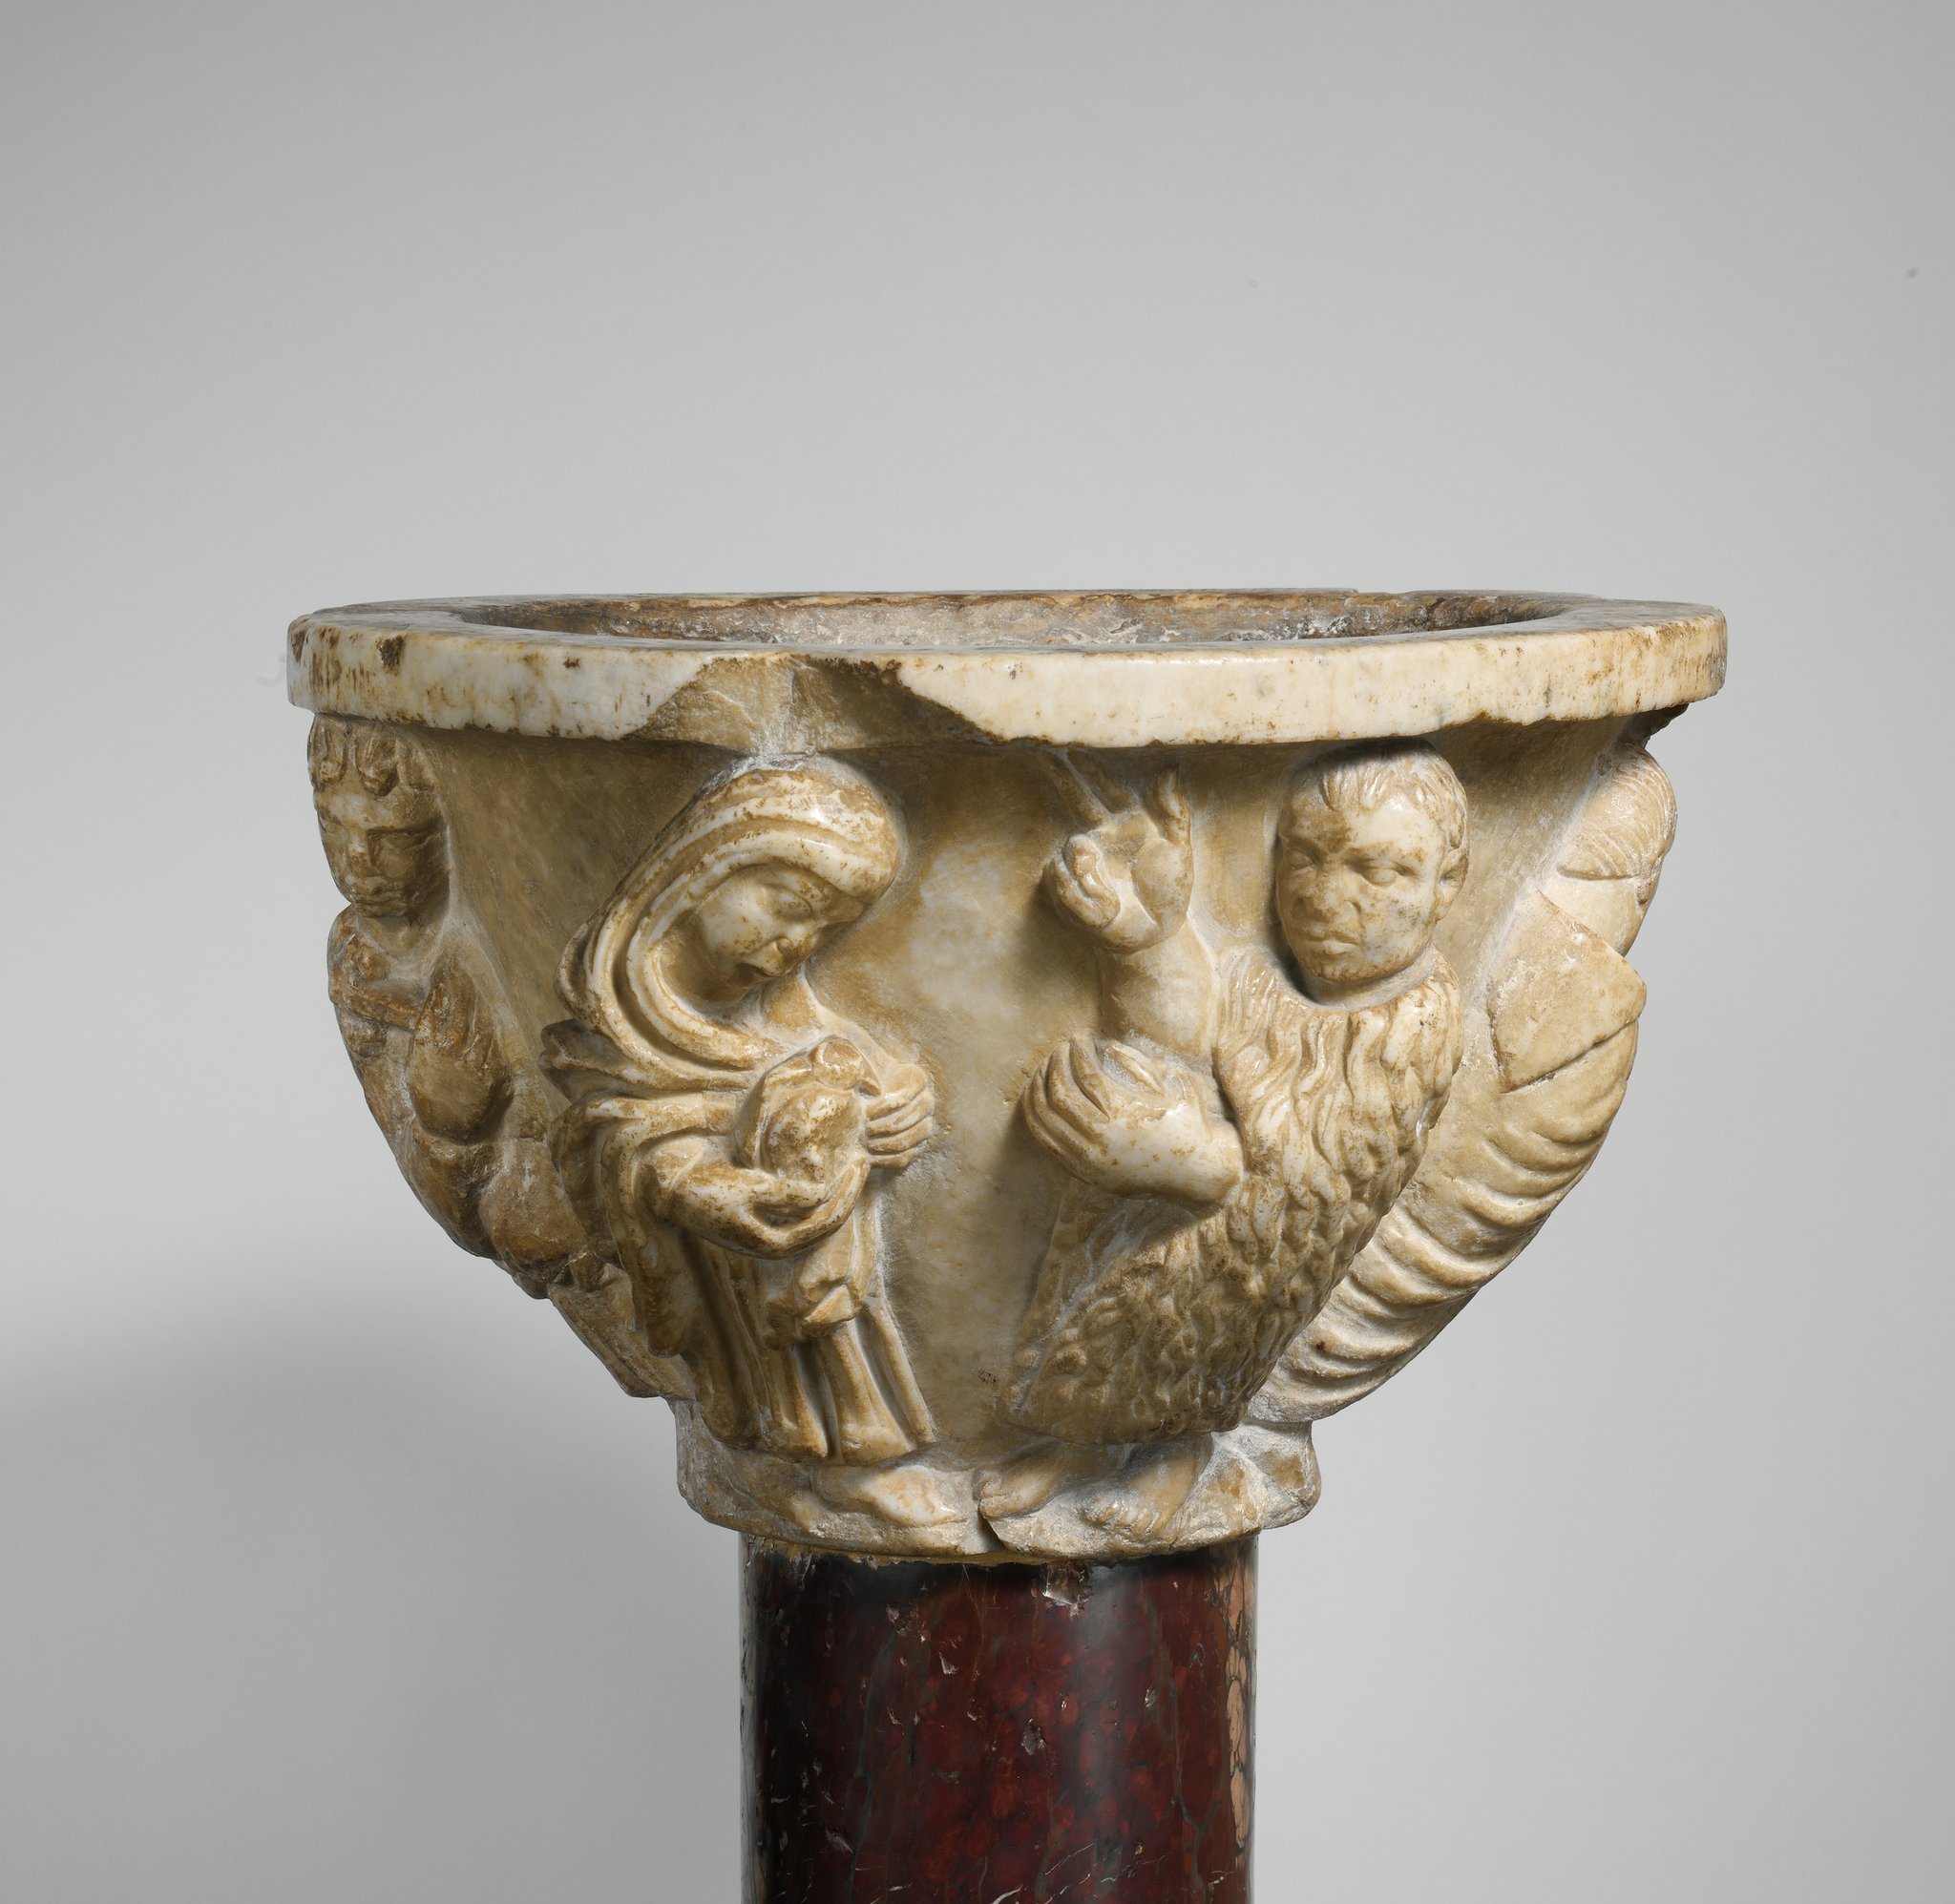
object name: font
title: Holy-water Font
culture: italian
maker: guglielmus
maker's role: artist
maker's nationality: italian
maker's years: 1158-1165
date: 1160-1165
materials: marble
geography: central italy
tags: men,saints